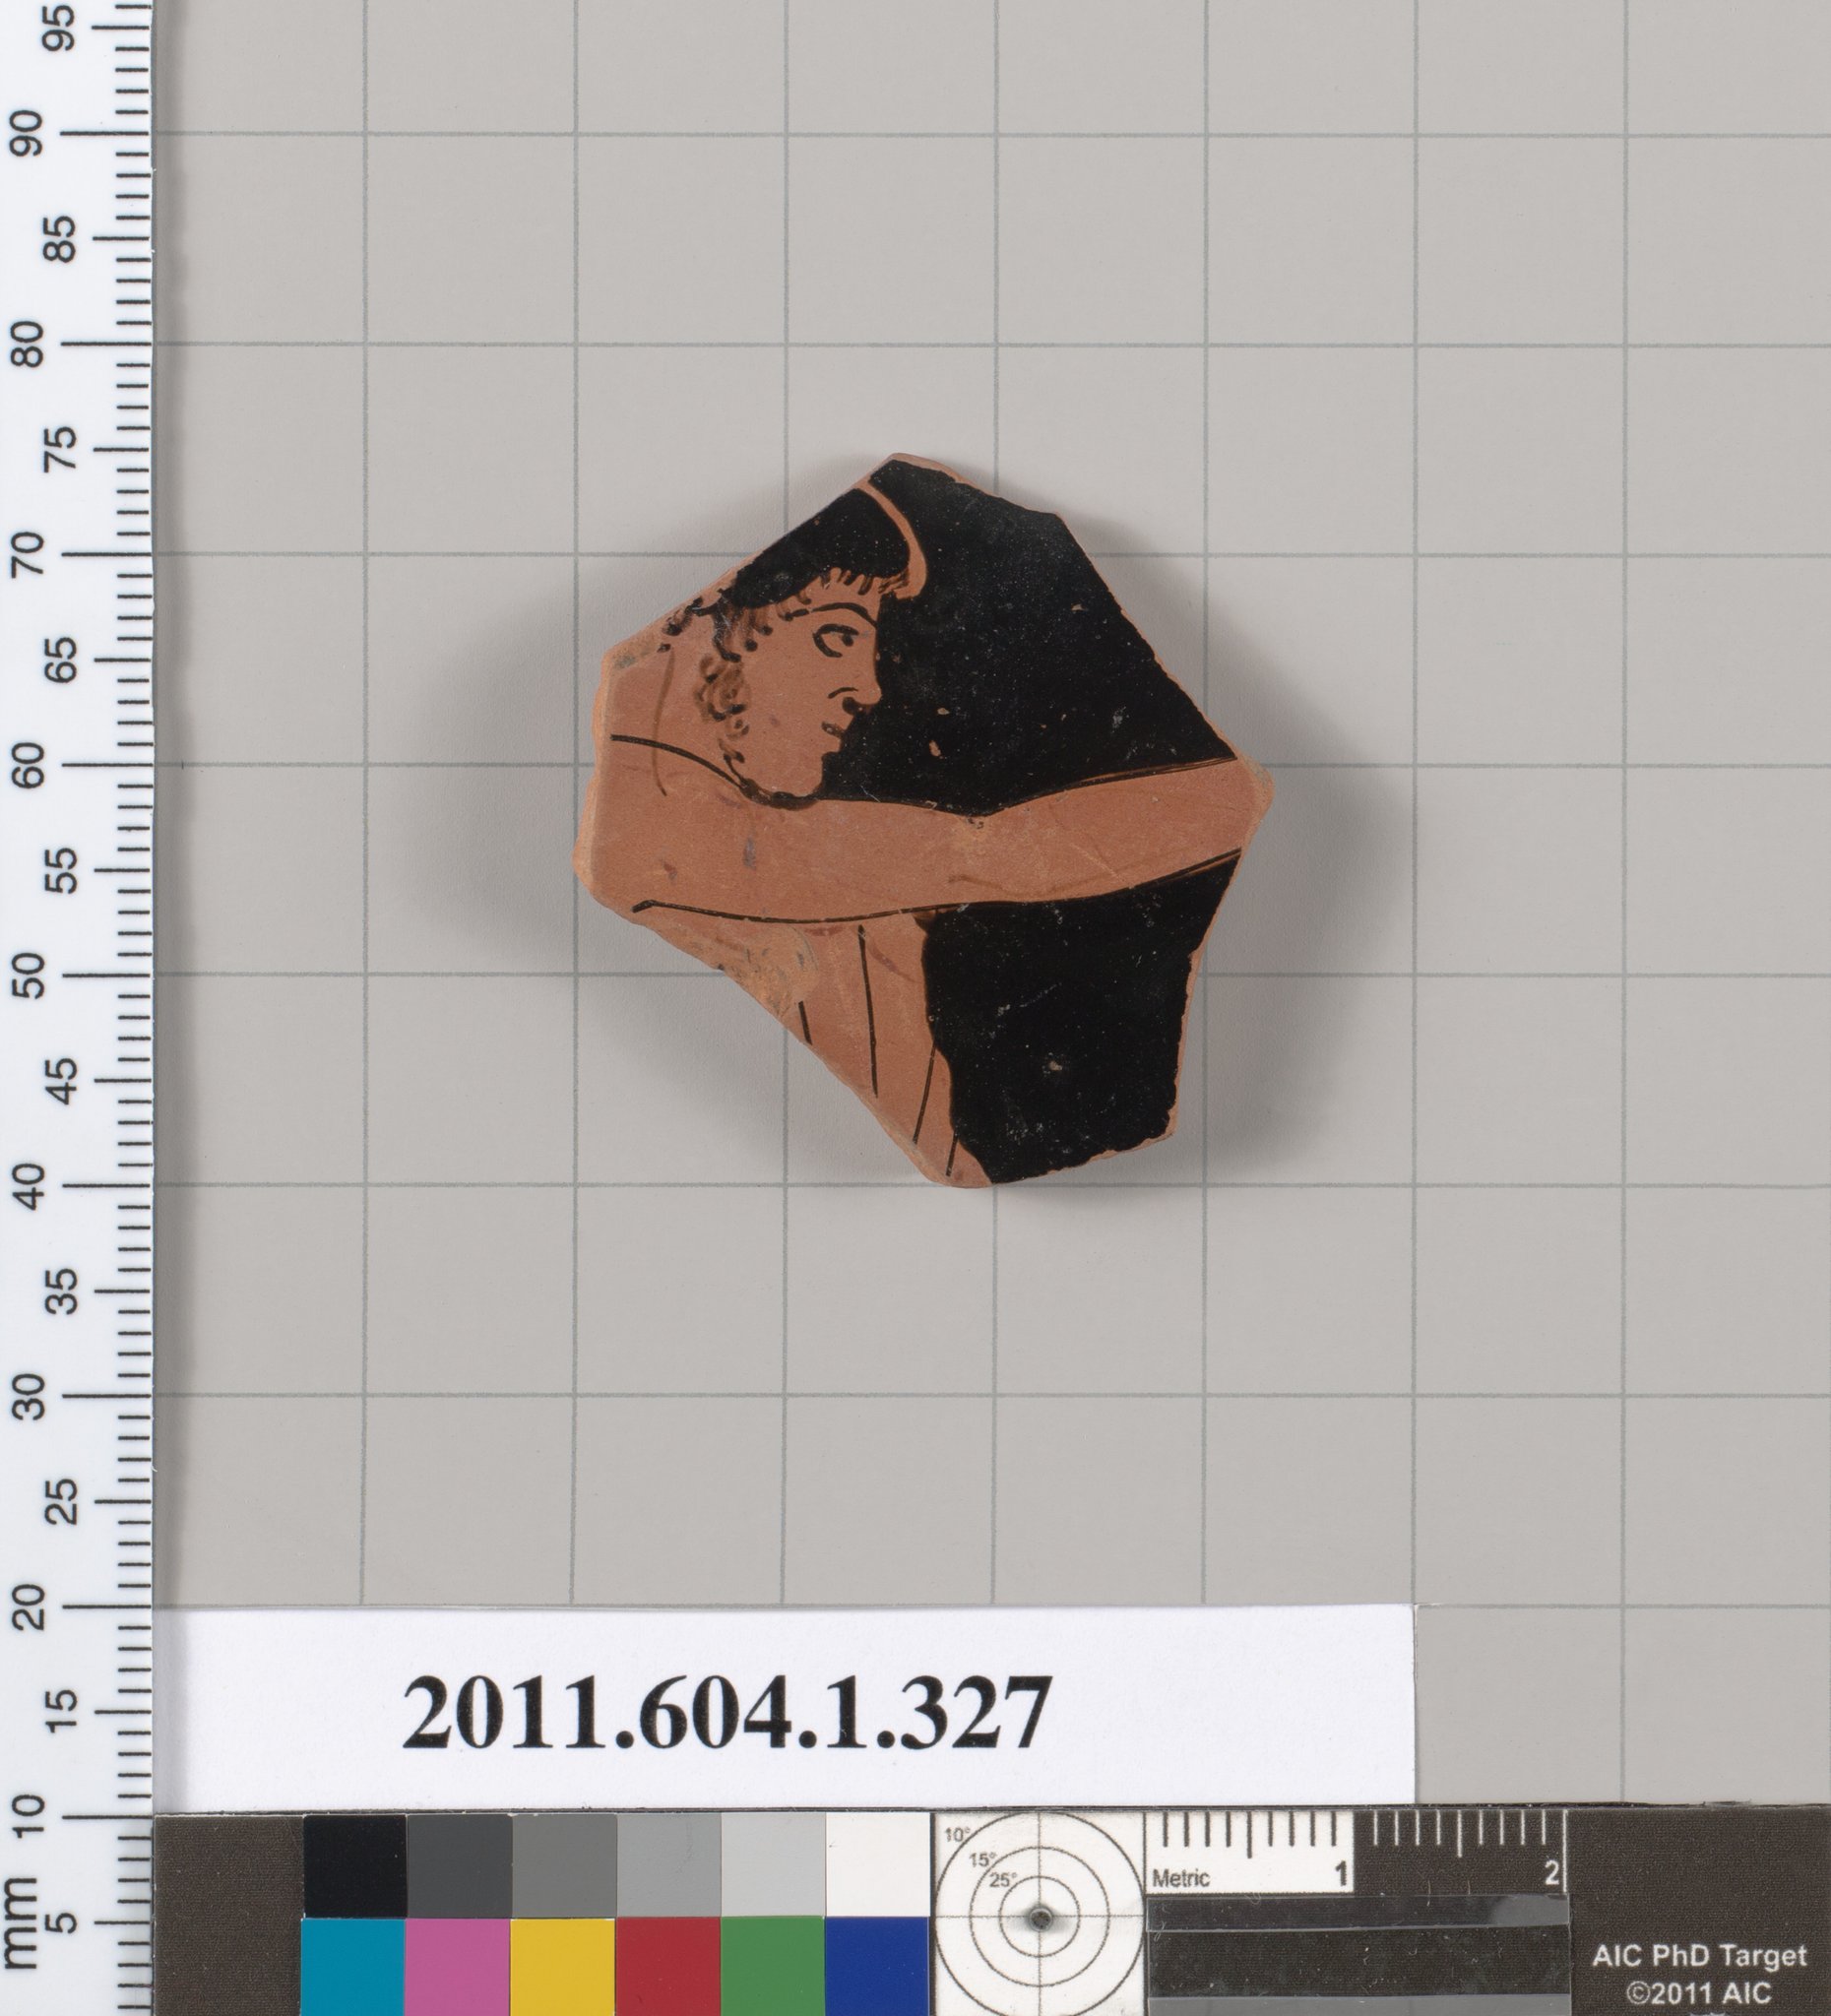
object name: kylix fragment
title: Terracotta fragment of a kylix (drinking cup)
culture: greek, attic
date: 475-451 BCE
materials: terracotta